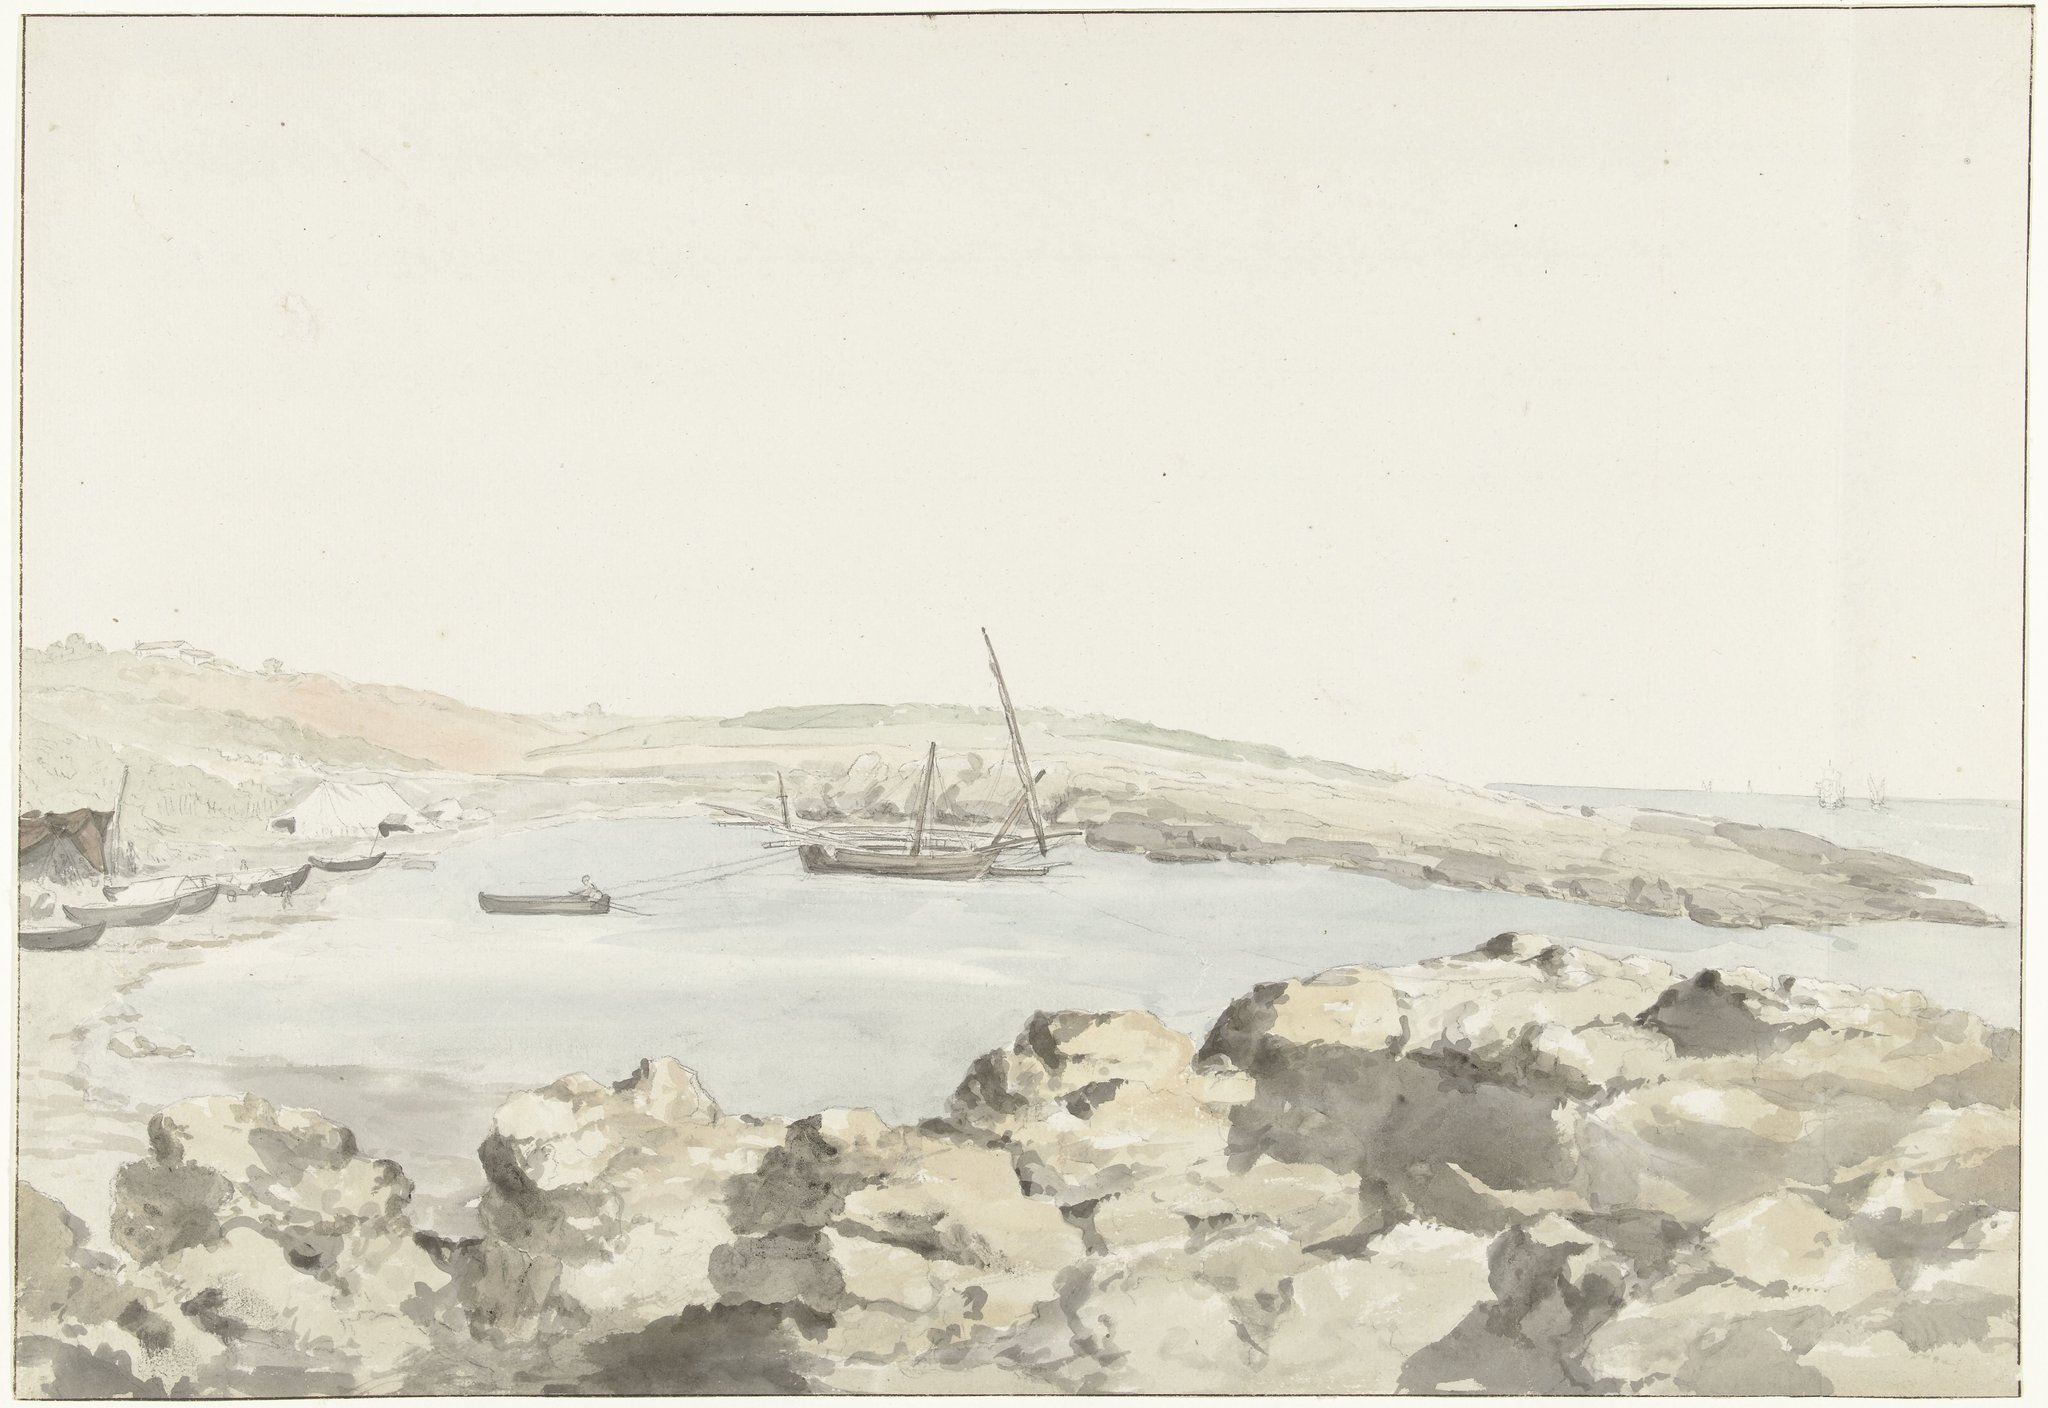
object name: watercolor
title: Vue par élévation du port de Luogo Vivo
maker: louis ducros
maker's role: draughtsman, print maker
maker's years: 1748-1810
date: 1778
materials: chalk, paper, watercolor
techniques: brush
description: Tekening uit het album 'Voyage en Italie, en Sicile et à Malte', 1778.